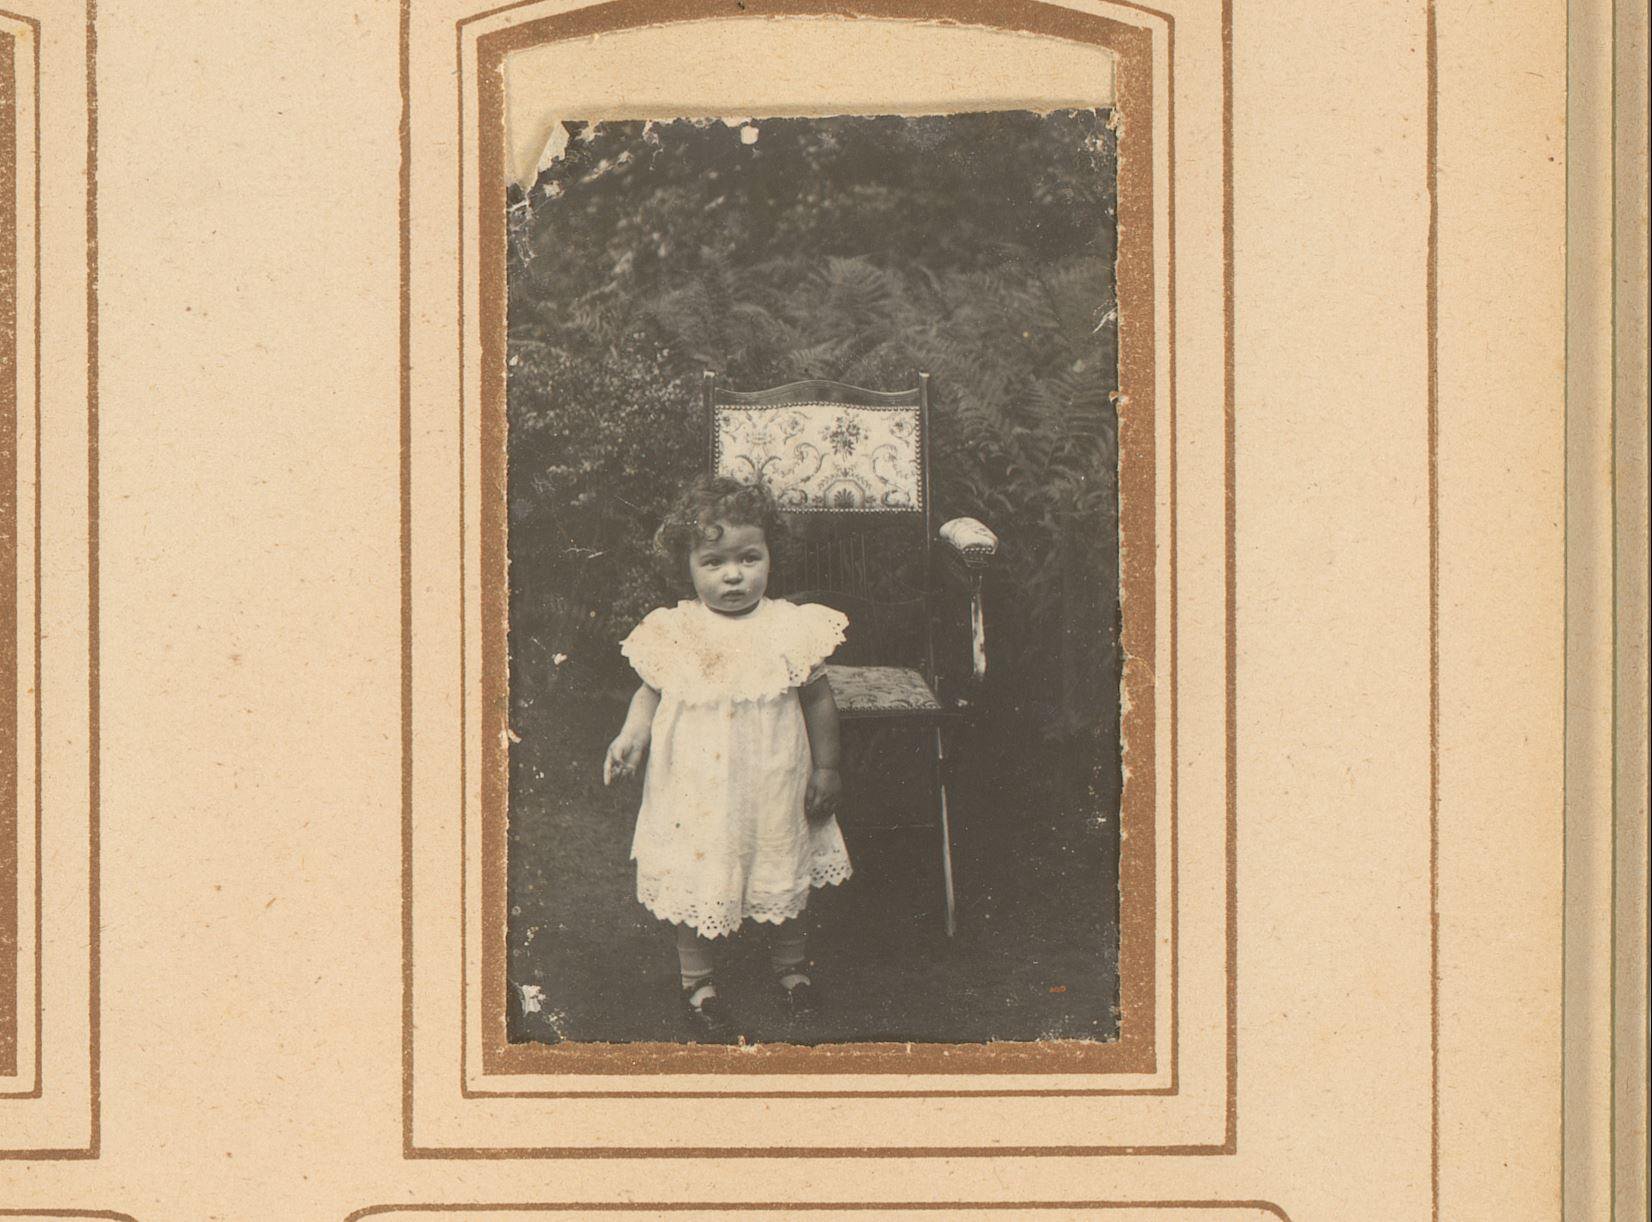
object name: album leaf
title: Portret van een meisje, buiten bij een stoel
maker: Anonymous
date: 1880-1920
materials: photographic support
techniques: collodion silver print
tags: girl (child between toddler and youth)